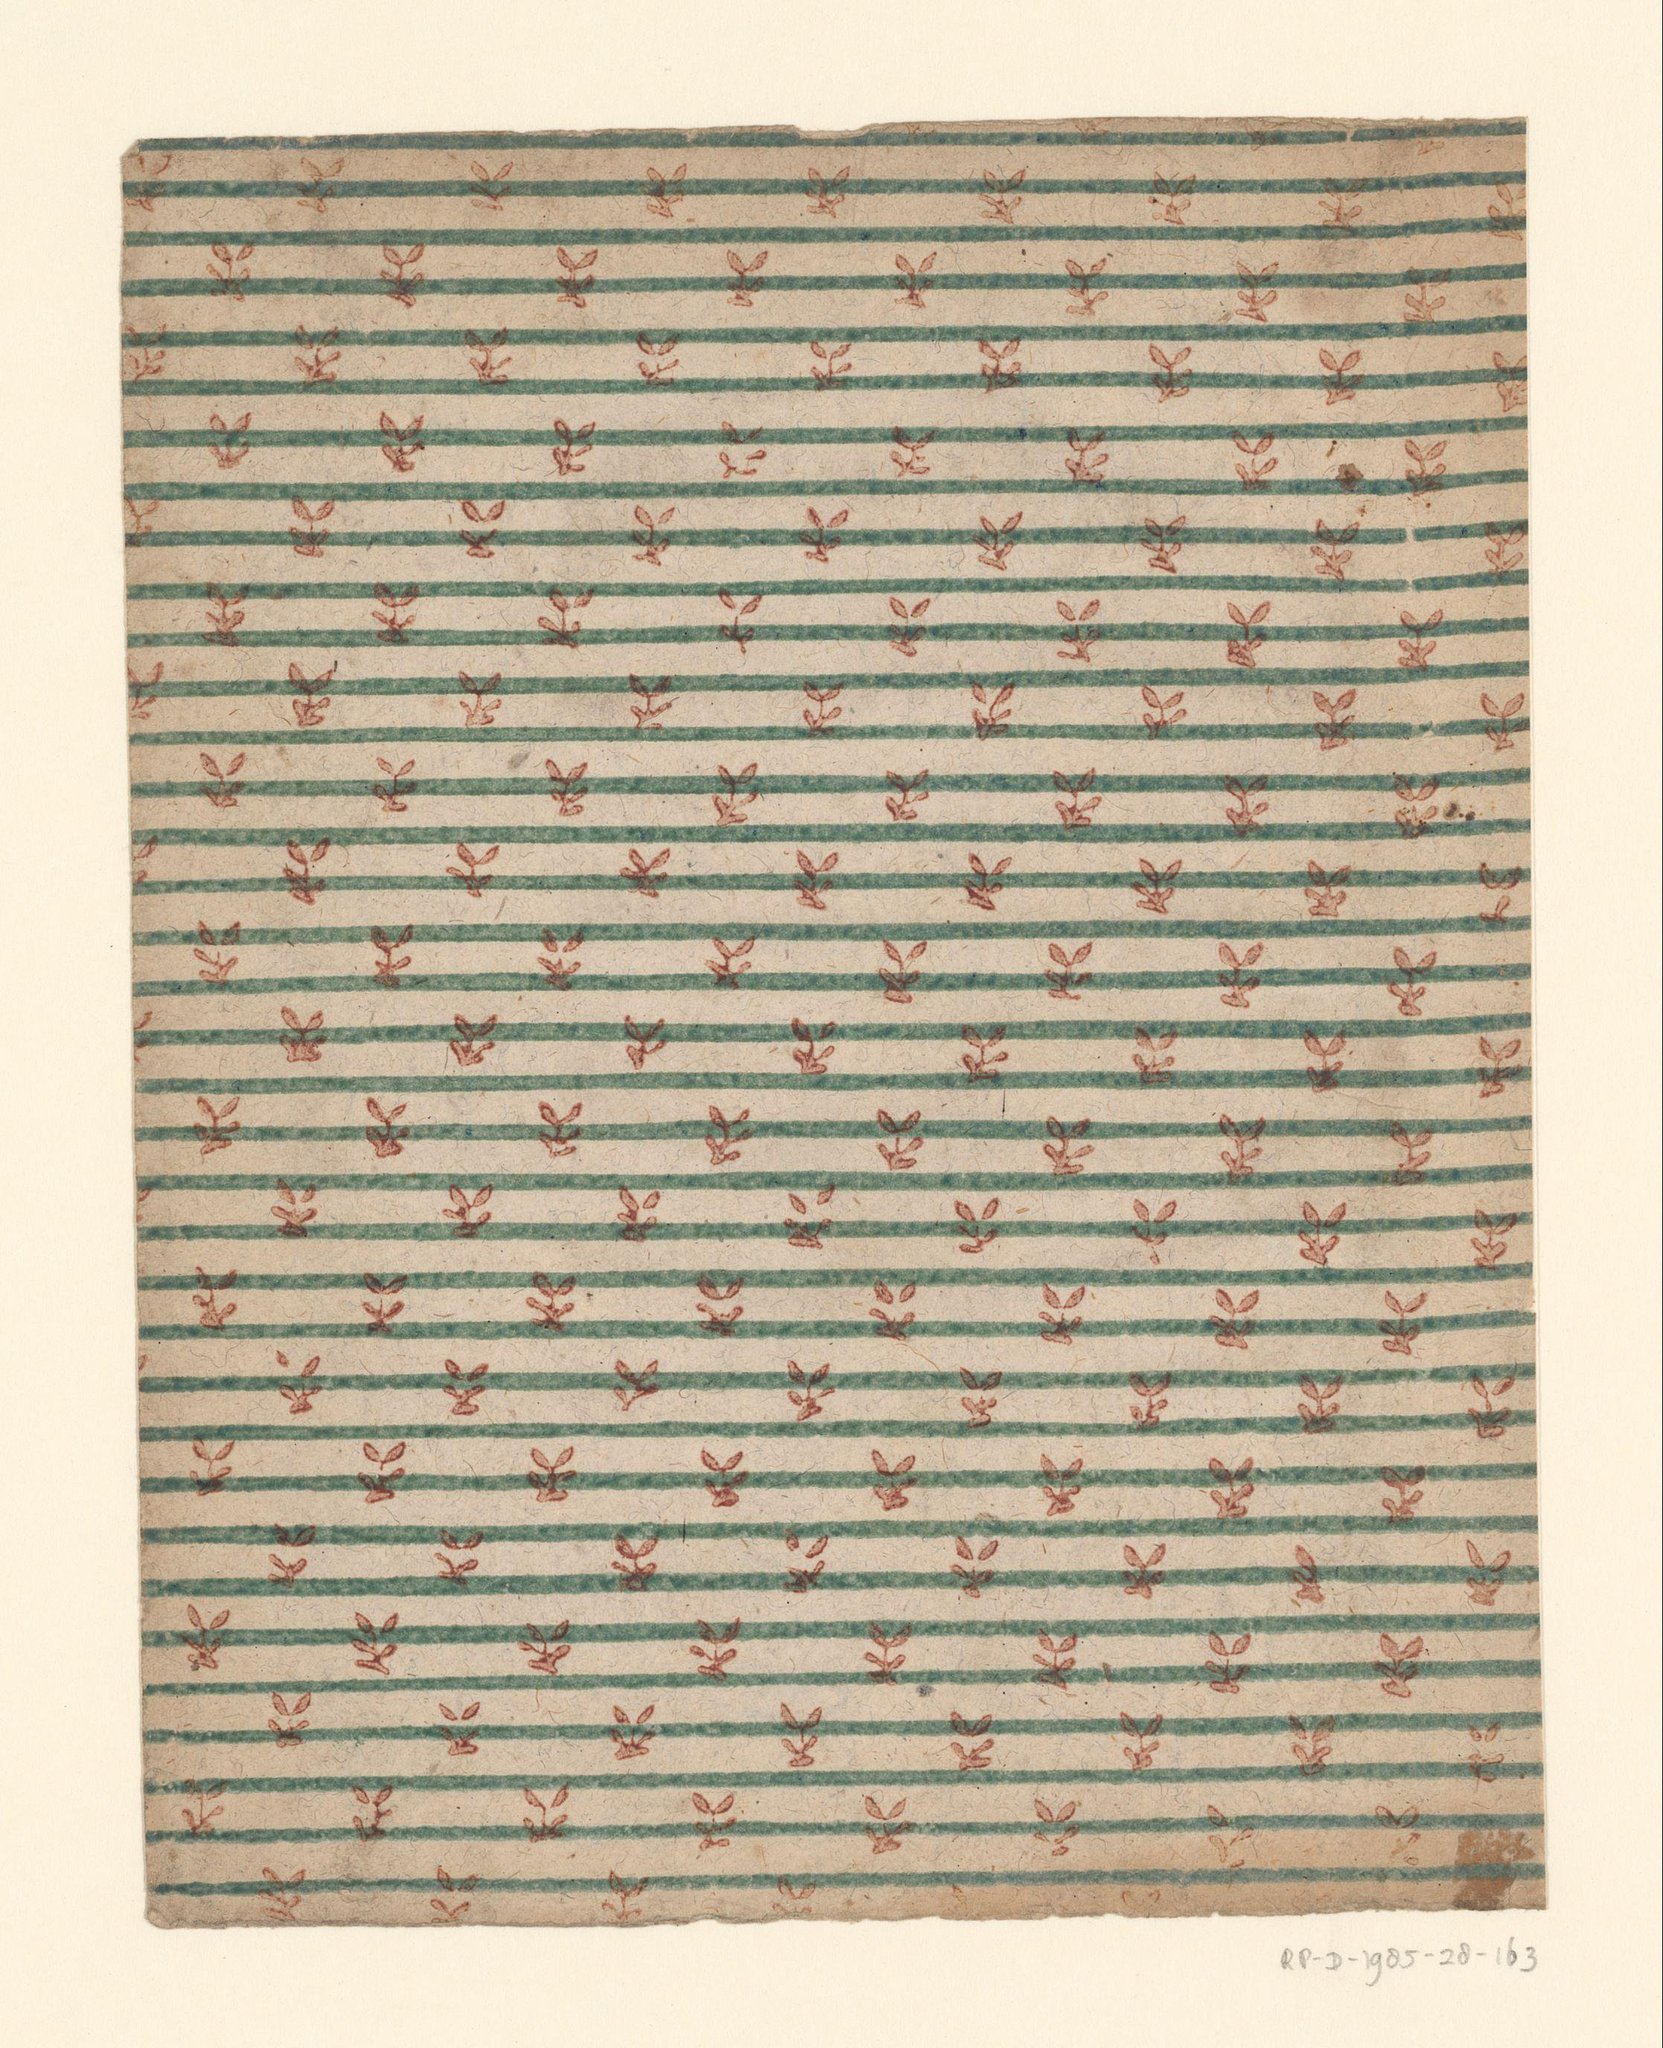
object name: printed paper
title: Blad met strooipatroon van takjes op doorlopend lijnenfond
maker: Anonymous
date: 1750-1900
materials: paper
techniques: printing block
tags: ornament derived from plant forms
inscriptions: collector's mark: Lugt 2760, collector's mark: Lugt 2228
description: Blad met strooipatroon van takjes op doorlopend lijnenfond. Helft van een omslag.